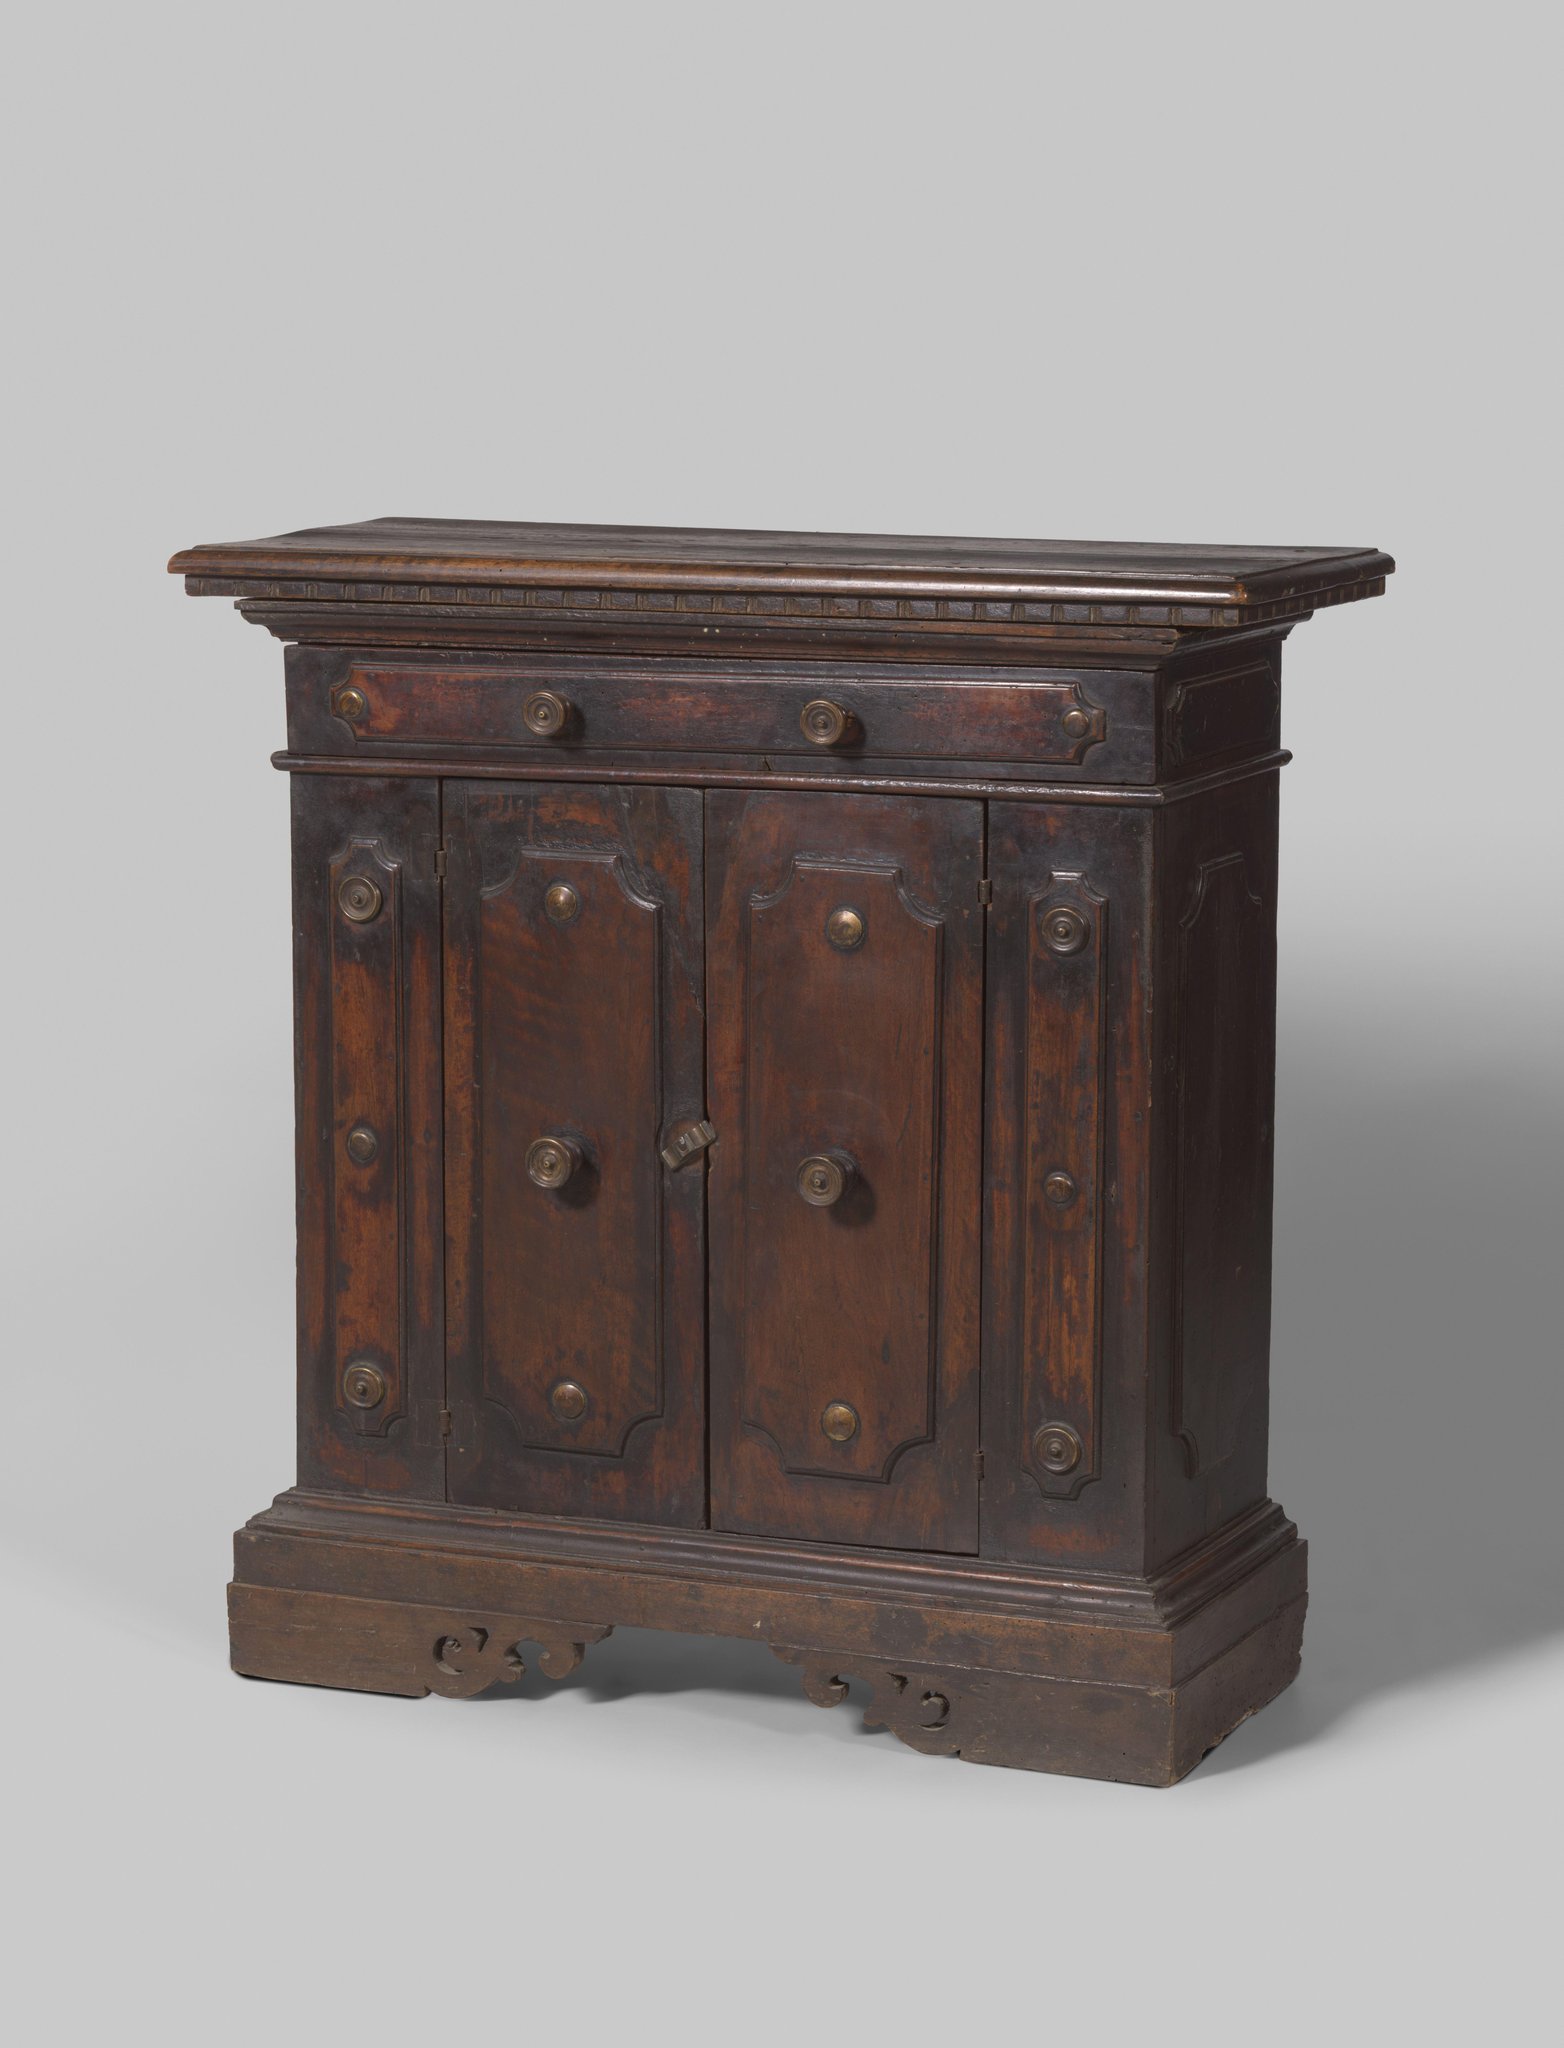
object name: cupboard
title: Wandkast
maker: Anonymous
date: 1500-1600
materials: copper, wood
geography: italy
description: Wandkast (credenzino) van notenhout, op staande plinten, waarvan de voorplint in het midden onderbroken wordt door uitgezaagde voluten. De kast heeft in het midden twee deuren met opgelegde panelen met afgeschuinde hoeken, geflankeerd door twee smalle soortgelijke panelen. De panelen vertonen gedraaid houten knoppen met geel koperen dekplaten en koperen knoppen. De treklade erboven heeft eveneens knoppen. Boven de lade een geprofileerde lijst met ver vooruitspringende dekplaat met tandlijst.